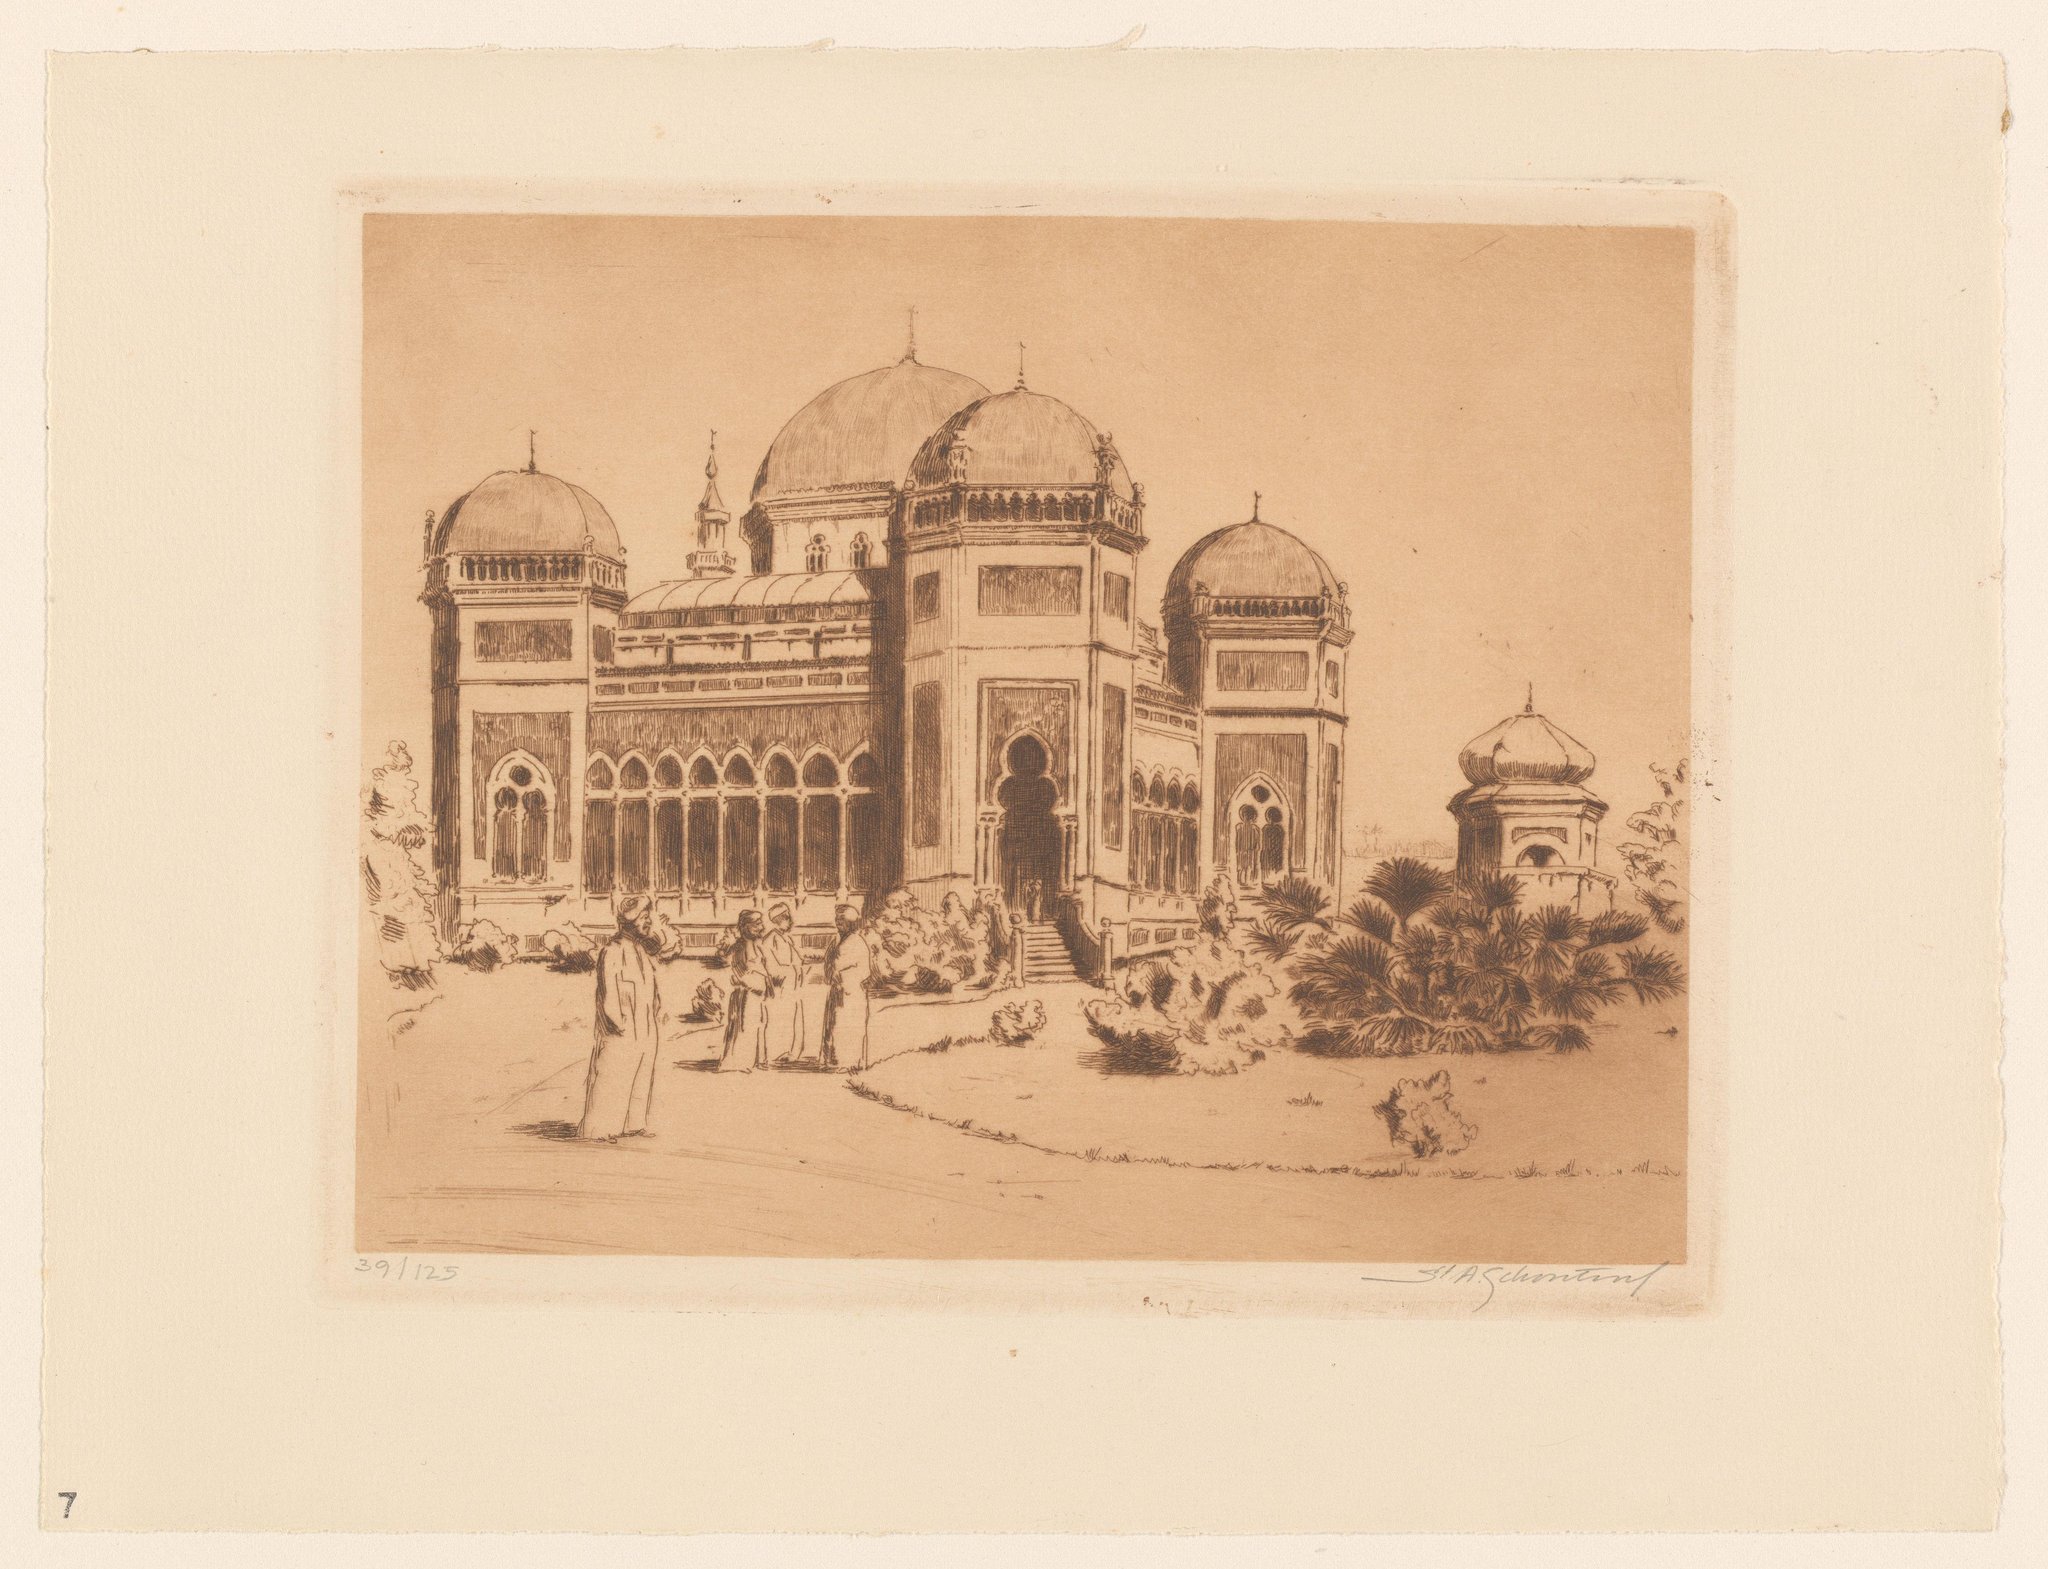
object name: print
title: Gezicht op een moskee bij Medan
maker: st. a. schouten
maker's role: print maker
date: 1929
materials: paper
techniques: etching, intaglio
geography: amsterdam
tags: temple, shrine ~ islam, mohammedanism, street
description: Aangezien geboorte- en sterfdatum van de kunstenaar onbekend zijn, is voor de rechtenbepaling van dit object de productiedatum gehanteerd.